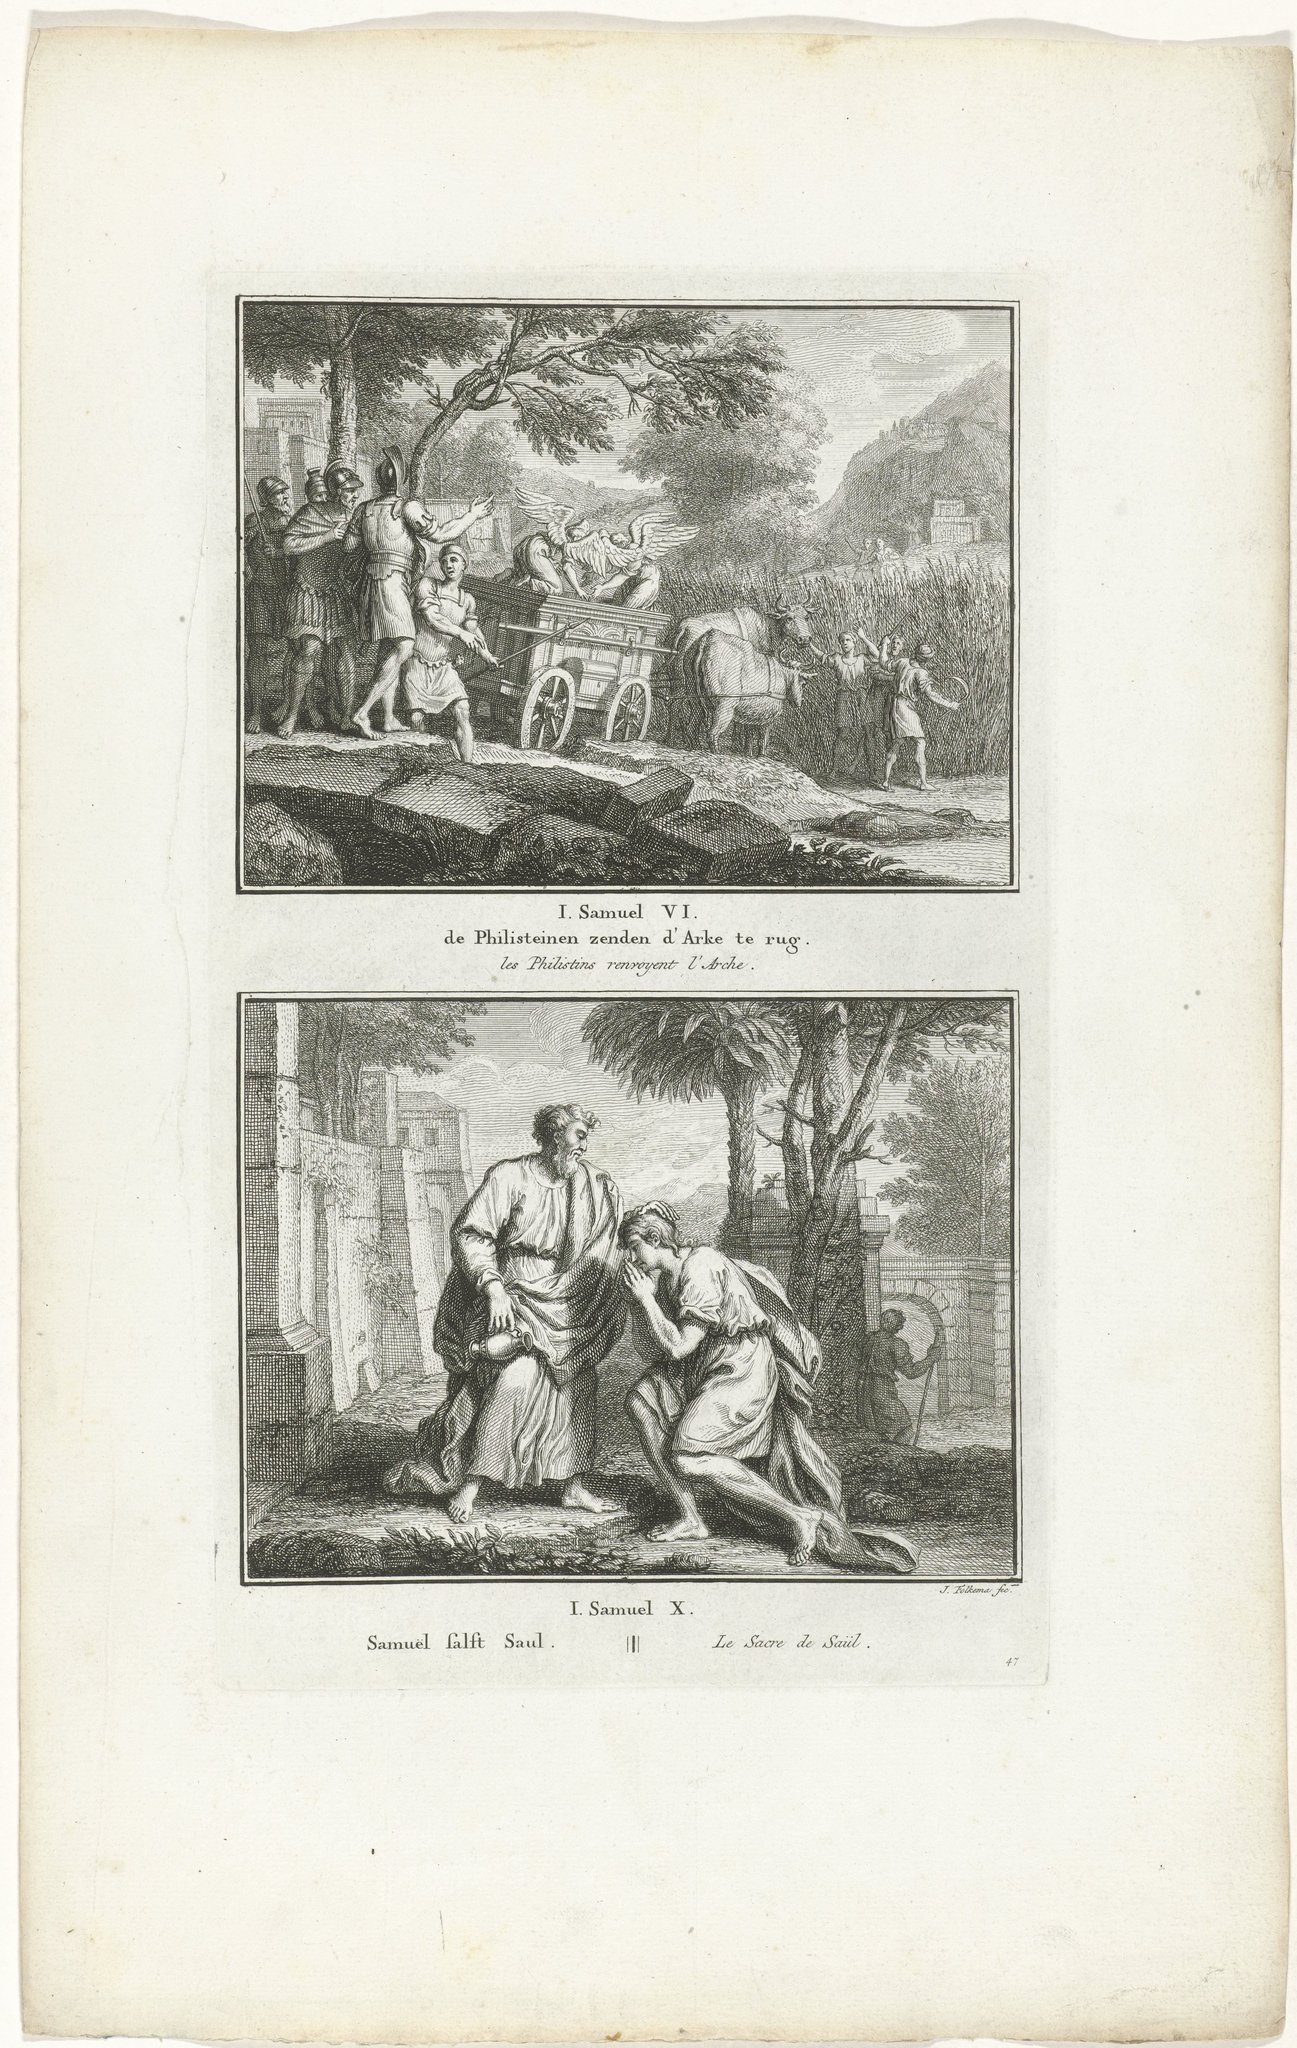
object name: book illustration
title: Filistijnen zenden de Ark des Verbonds terug naar Israël en Samuel zalft Saul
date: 1791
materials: paper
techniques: etching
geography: dordrecht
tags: god commands samuel to anoint saul, the ark of the covenant and the box with the guilt offering, drawn by two cows, sent back to israel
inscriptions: collector's mark: Lugt 2233, collector's mark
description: Illustratie uit: Hamelsveld, Ysbrand van. De gewigtigste geschiedenissen des Bybels, afgebeeld in twee honderd twee en vijftig printverbeeldingen (...) met eene zaaklijke uitbreiding opgehelderd. Amsterdam / Dordrecht: Jan de Groot / Abraham en Pieter Blussé.